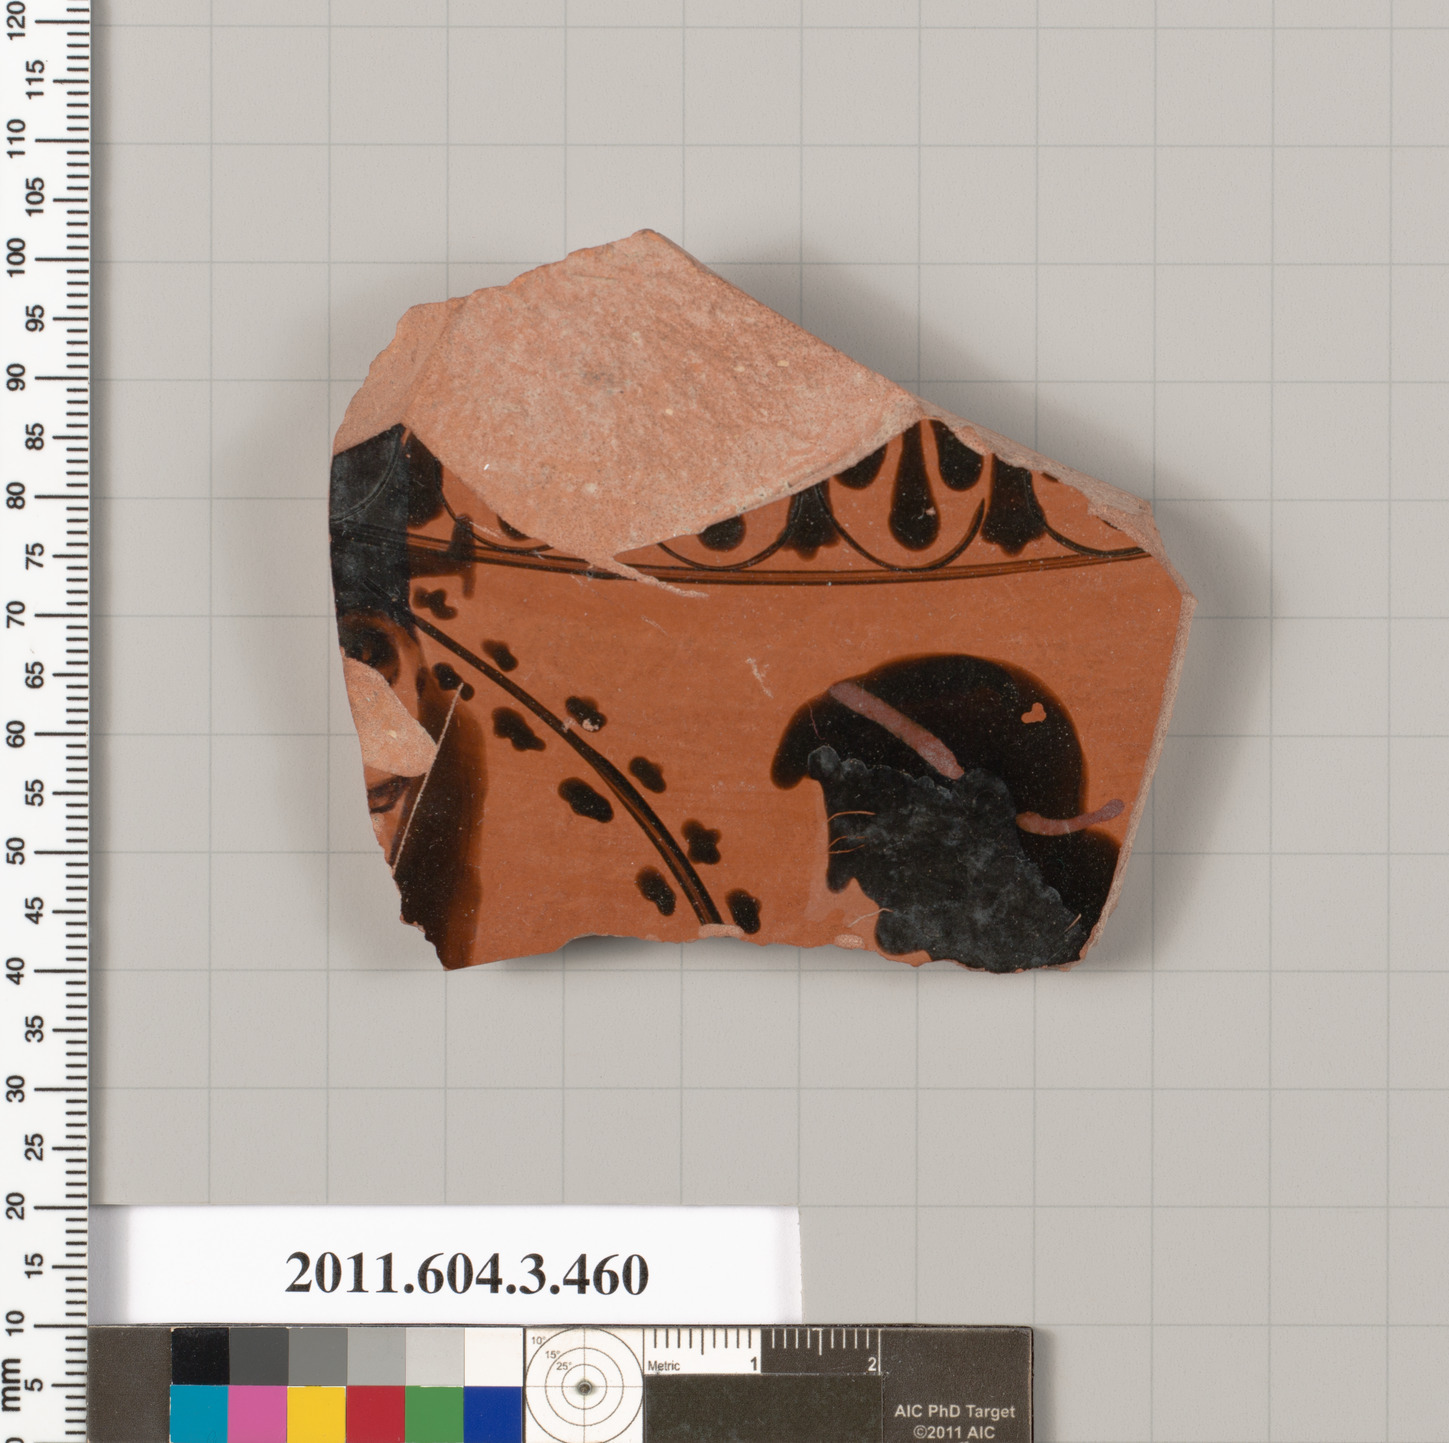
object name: amphora fragment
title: Terracotta fragment of an amphora (jar)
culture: greek, attic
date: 500-468 BCE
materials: terracotta